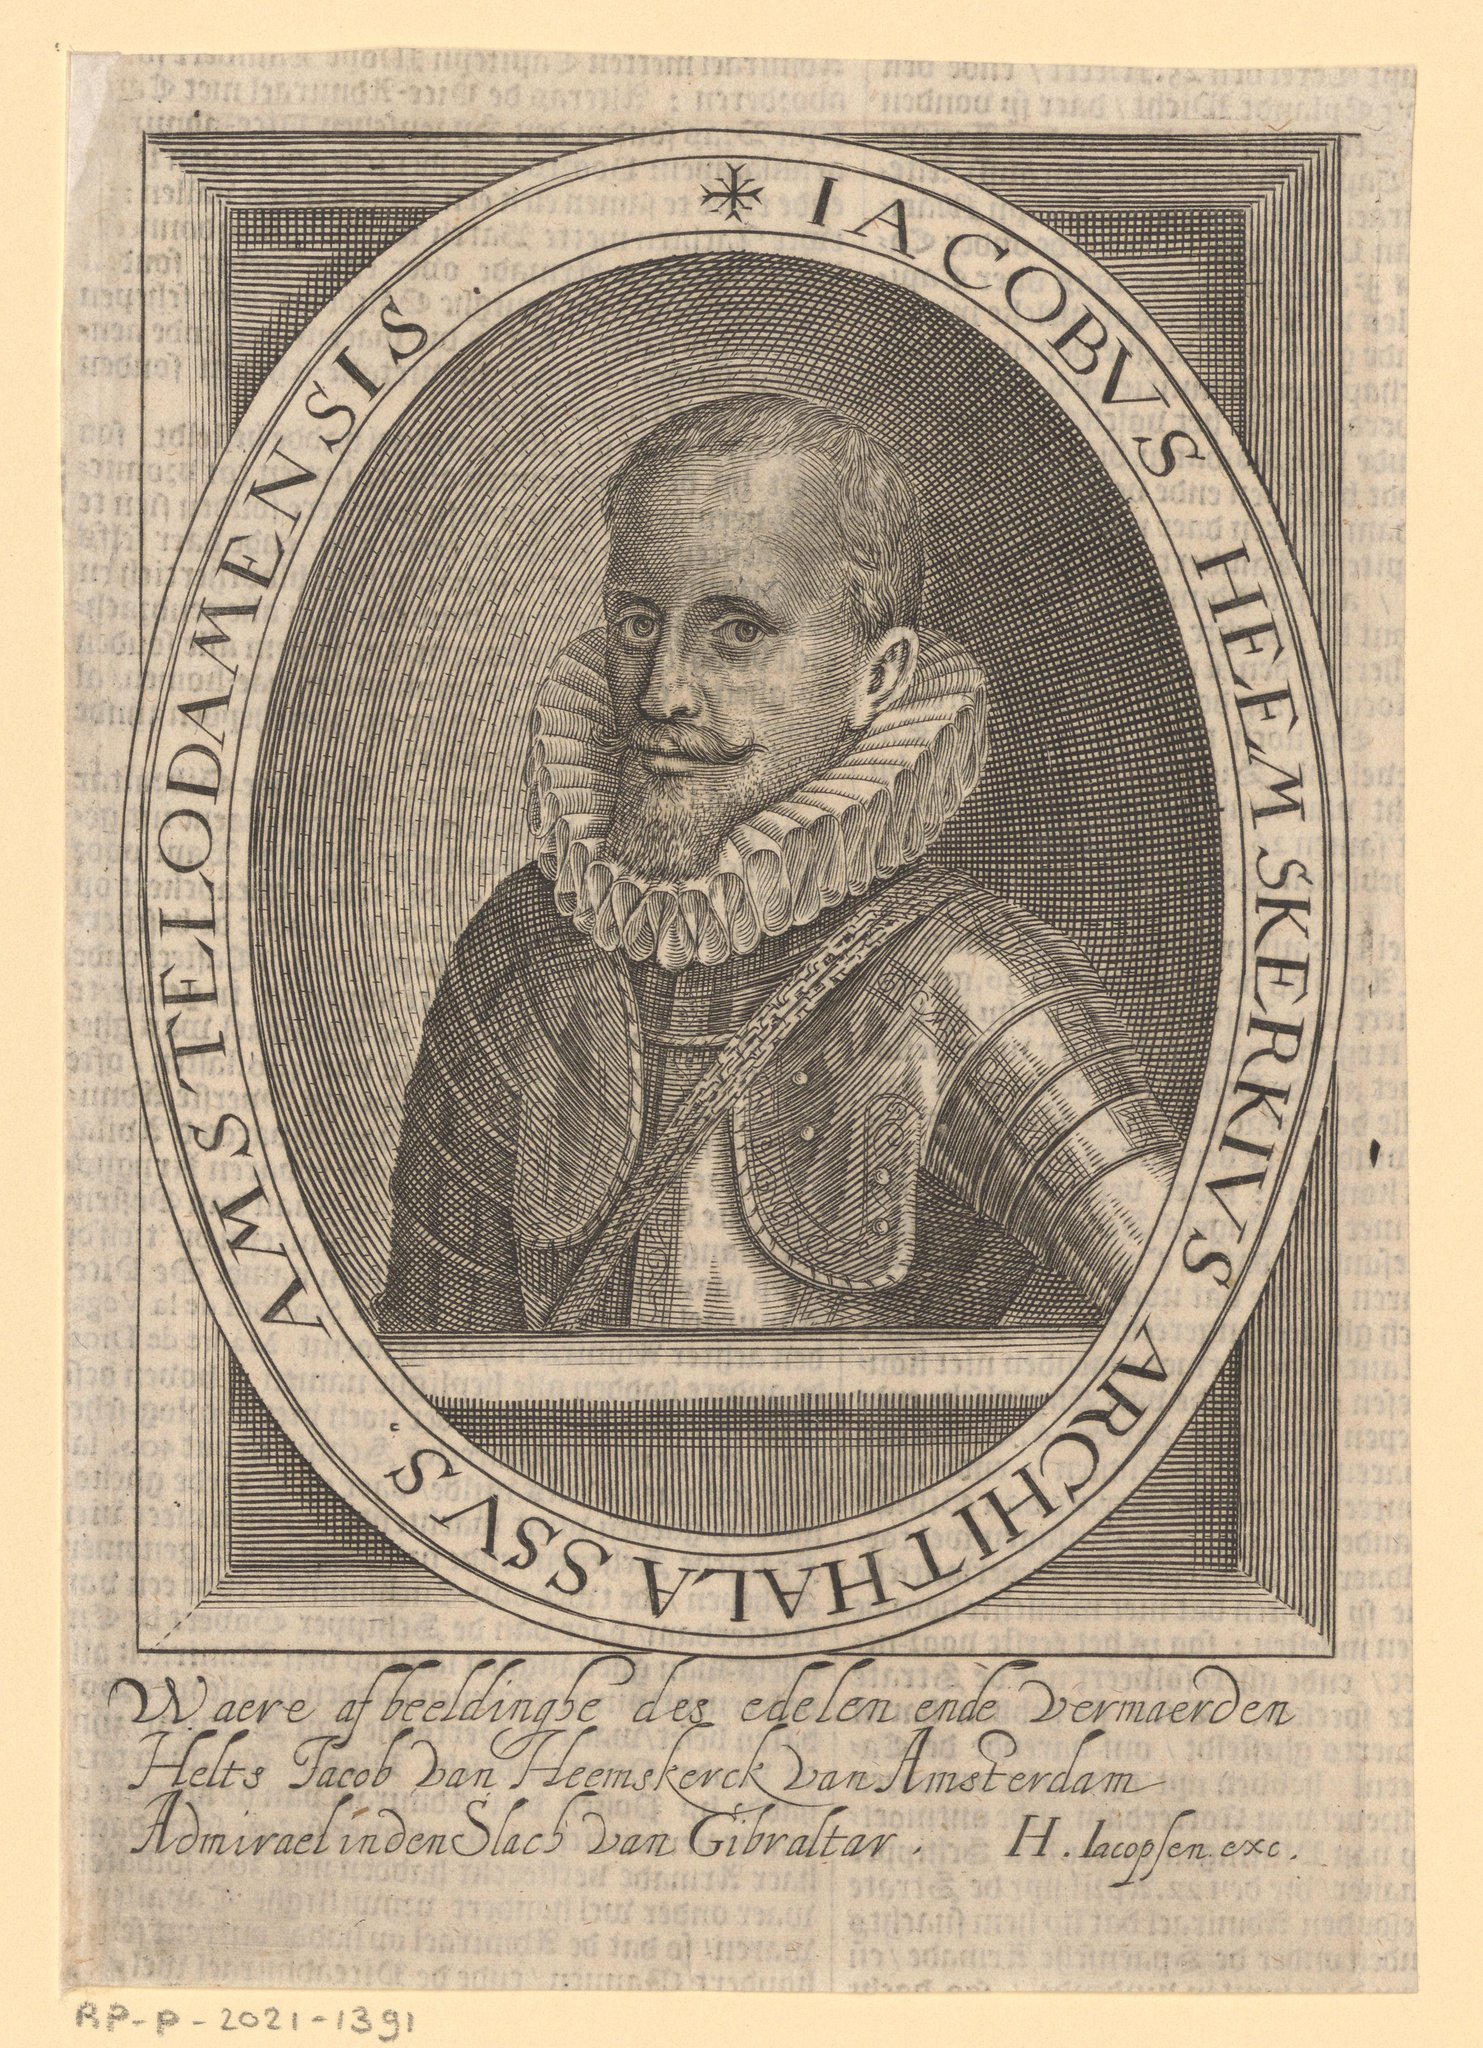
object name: print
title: Portret van Jacob van Heemskerck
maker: Anonymous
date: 1623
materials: paper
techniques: engraving, letterpress printing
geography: the hague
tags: amsterdam, jacob van heemskerck, armour, historical persons, commander-in-chief, admiral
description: Prent uit: Meteren, Emanuel van. Historie der Nederlandscher ender haerder naburen oorlogen ende geschiedenissen (...). Den Haag: weduwe en erven van Hillebrant Jacobsz van Wouw, 1623, f. 564. Prent ook gebruikt in latere edities van dit werk.